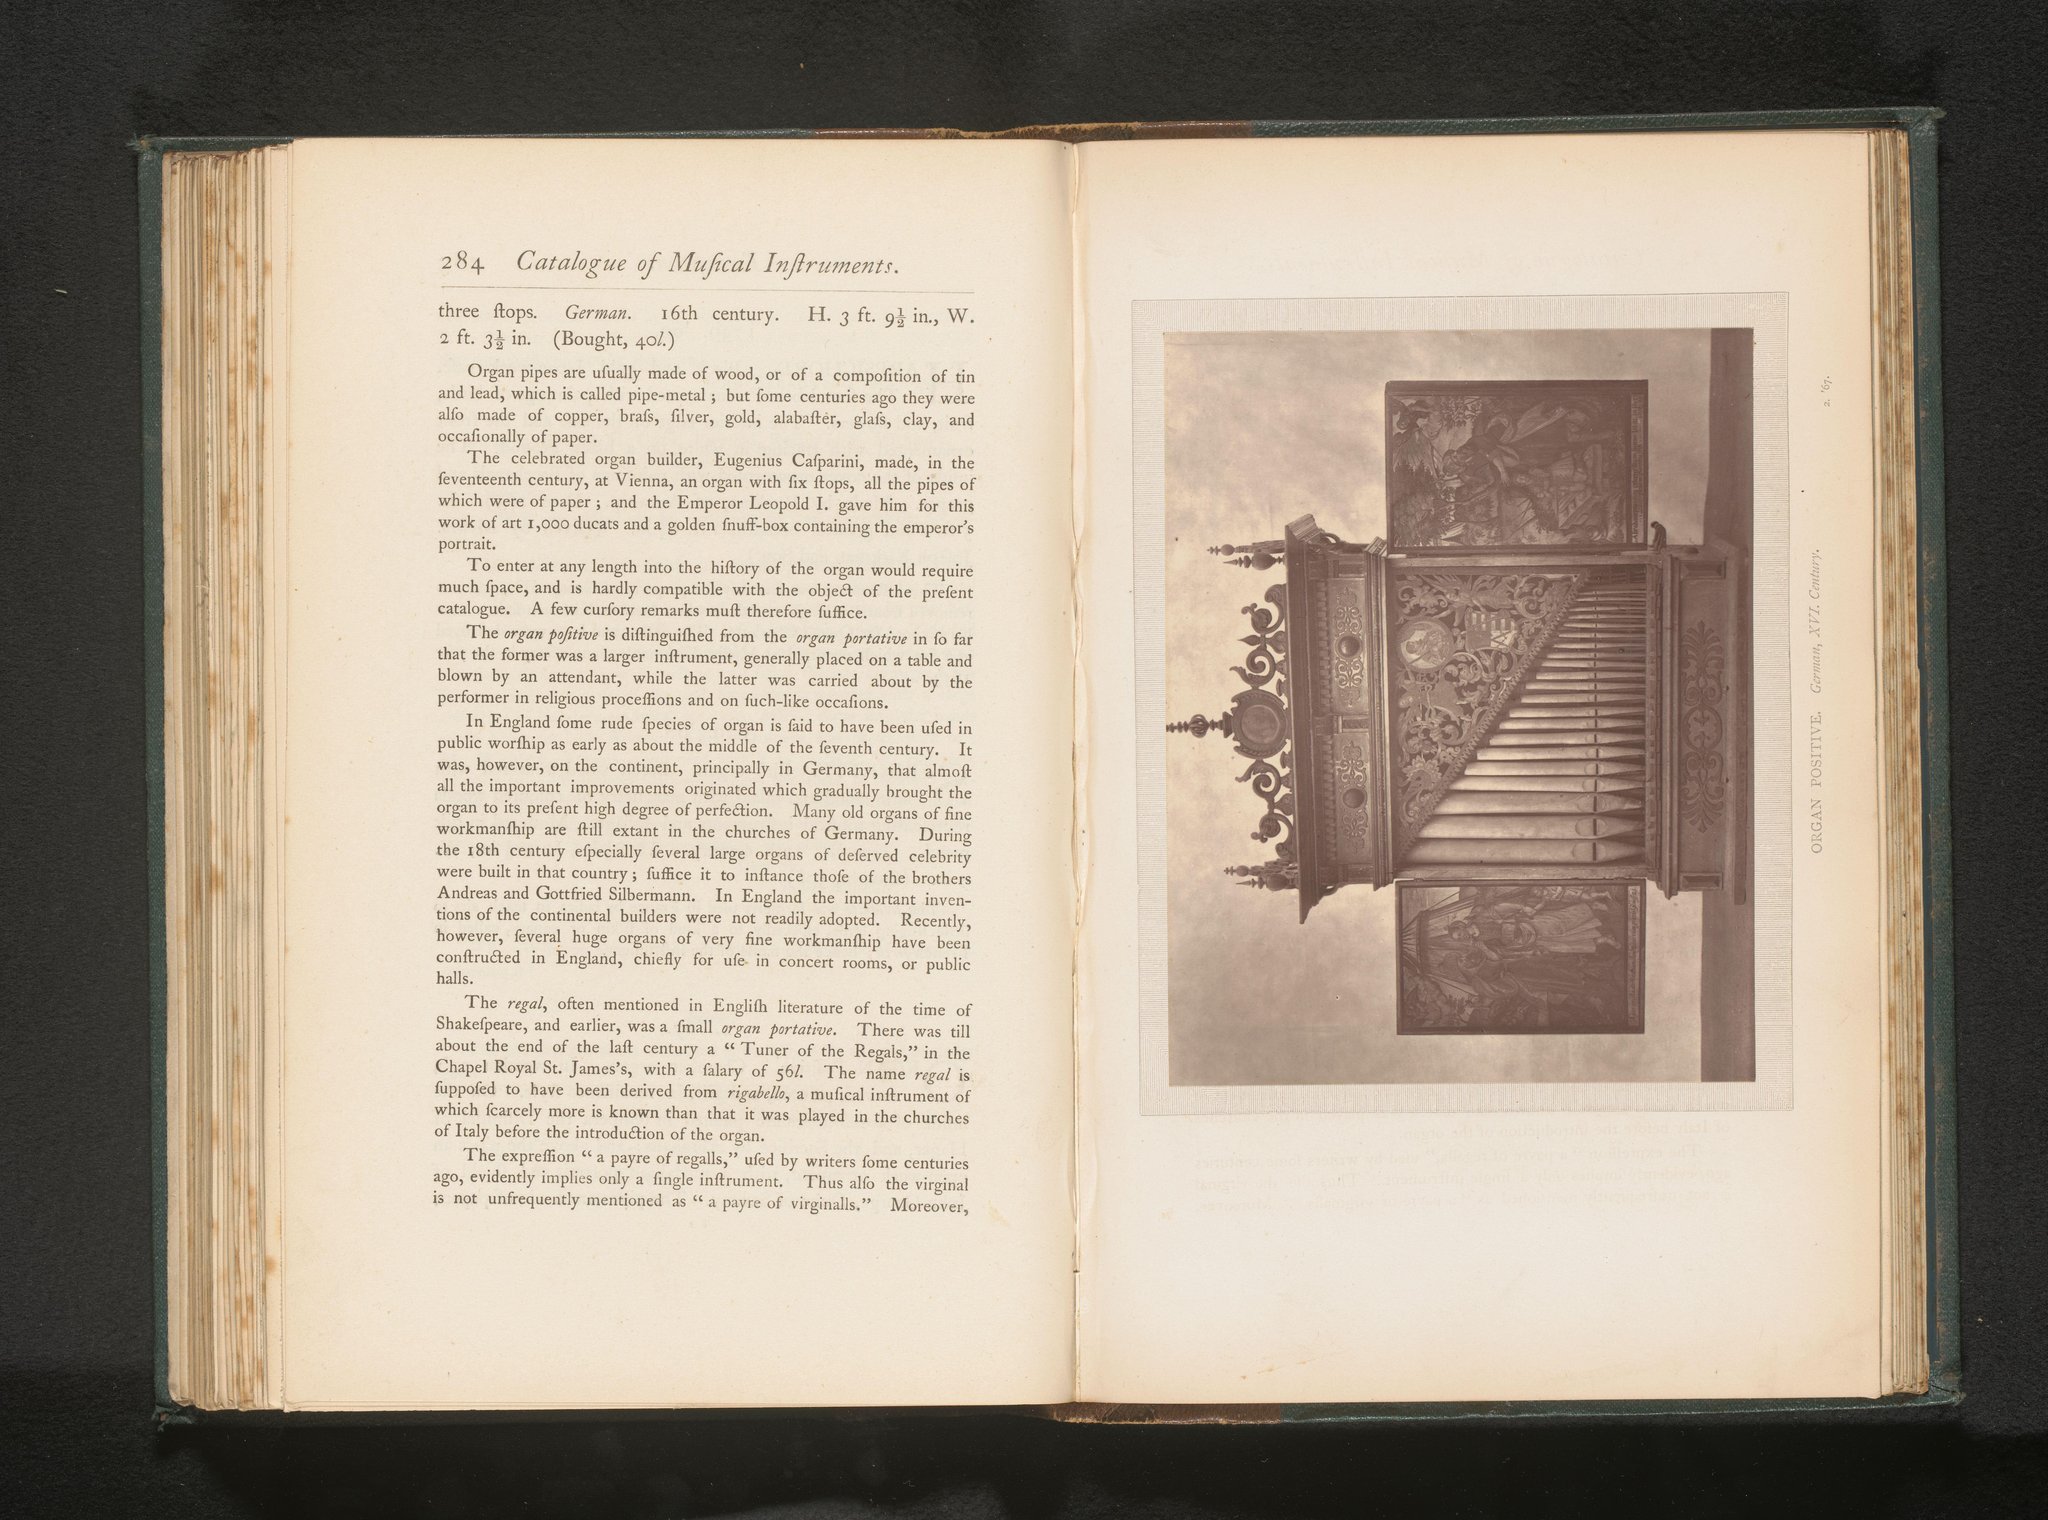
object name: page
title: Orgel van het South Kensington Museum te Londen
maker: Anonymous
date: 1869-1874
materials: paper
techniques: woodburytype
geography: london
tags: organ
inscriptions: inscription: ‘Organ positive. German, XVI. Century.’